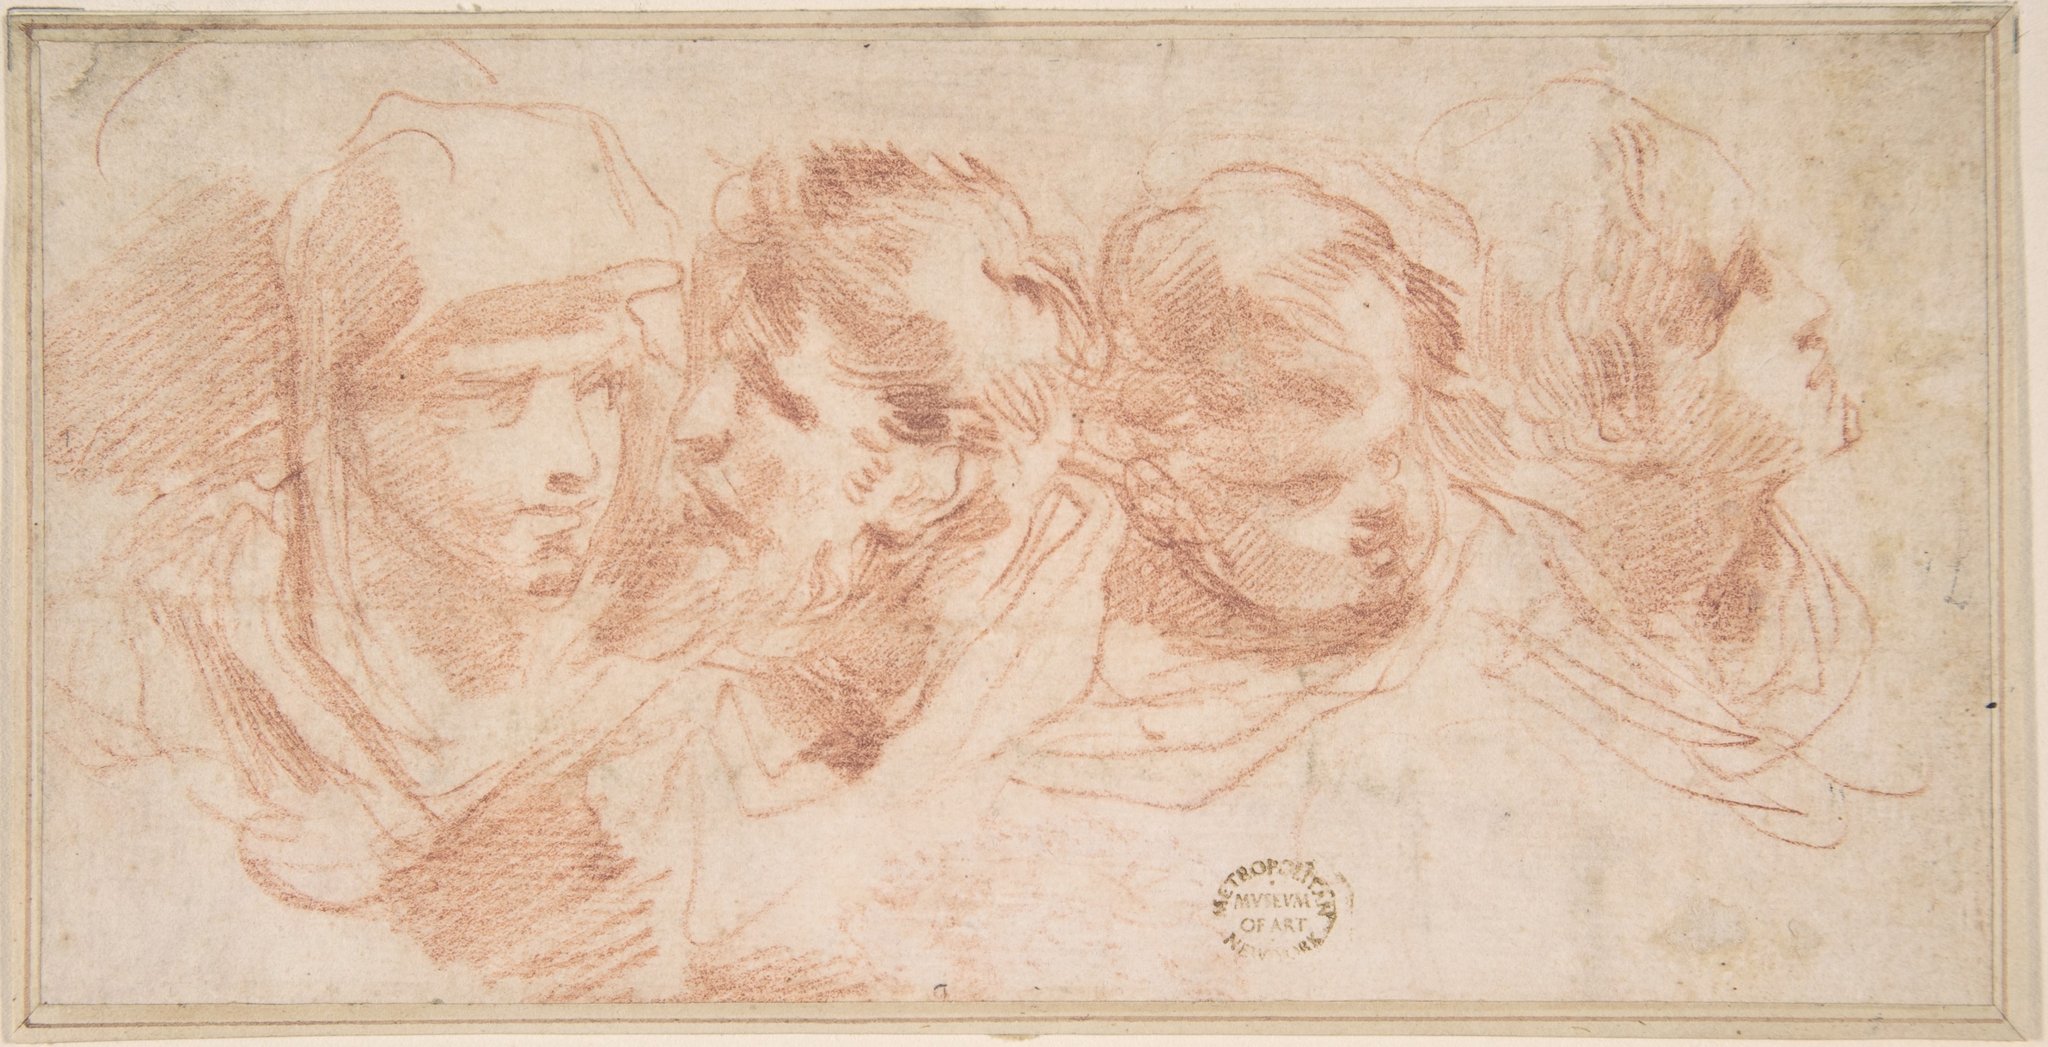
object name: drawing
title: Studies of Four Heads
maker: anonymous, italian, roman-bolognese, 17th century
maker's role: artist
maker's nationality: italian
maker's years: 1600-1700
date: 1601-1700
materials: chalk, paper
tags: human figures,heads